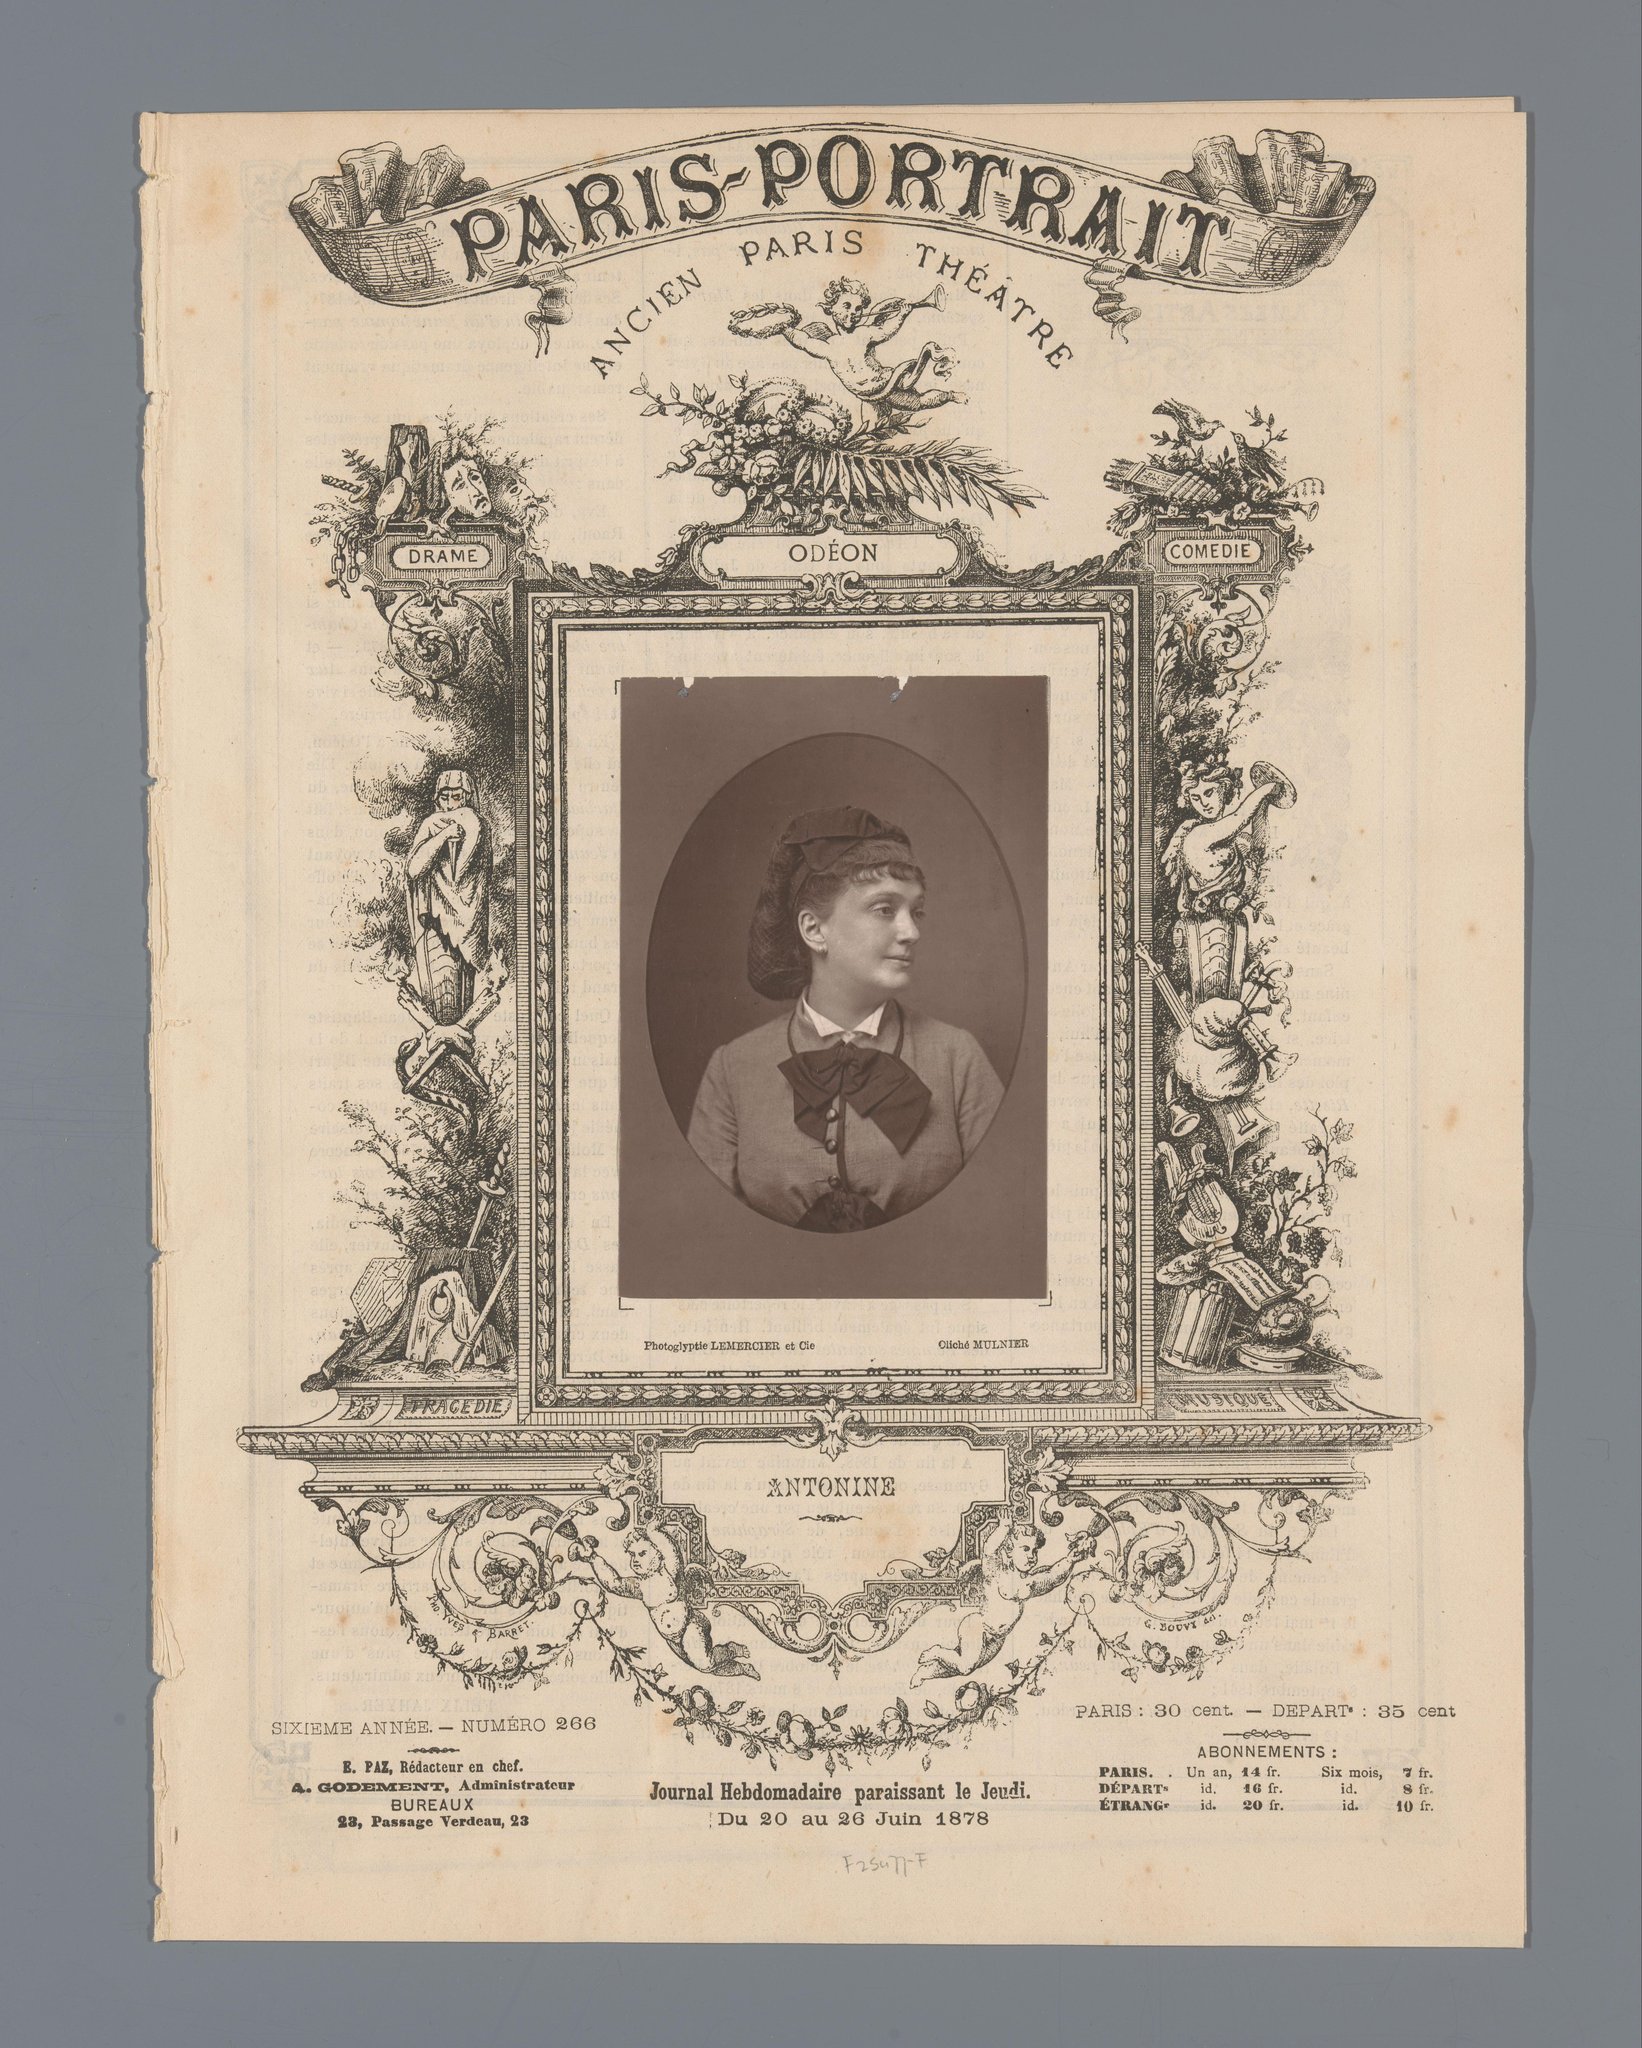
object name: photomechanical print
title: Antonine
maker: ferdinand mulnier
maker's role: painter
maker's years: 1817-1891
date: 1873-1880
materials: paper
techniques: woodburytype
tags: historical persons - bb - woman